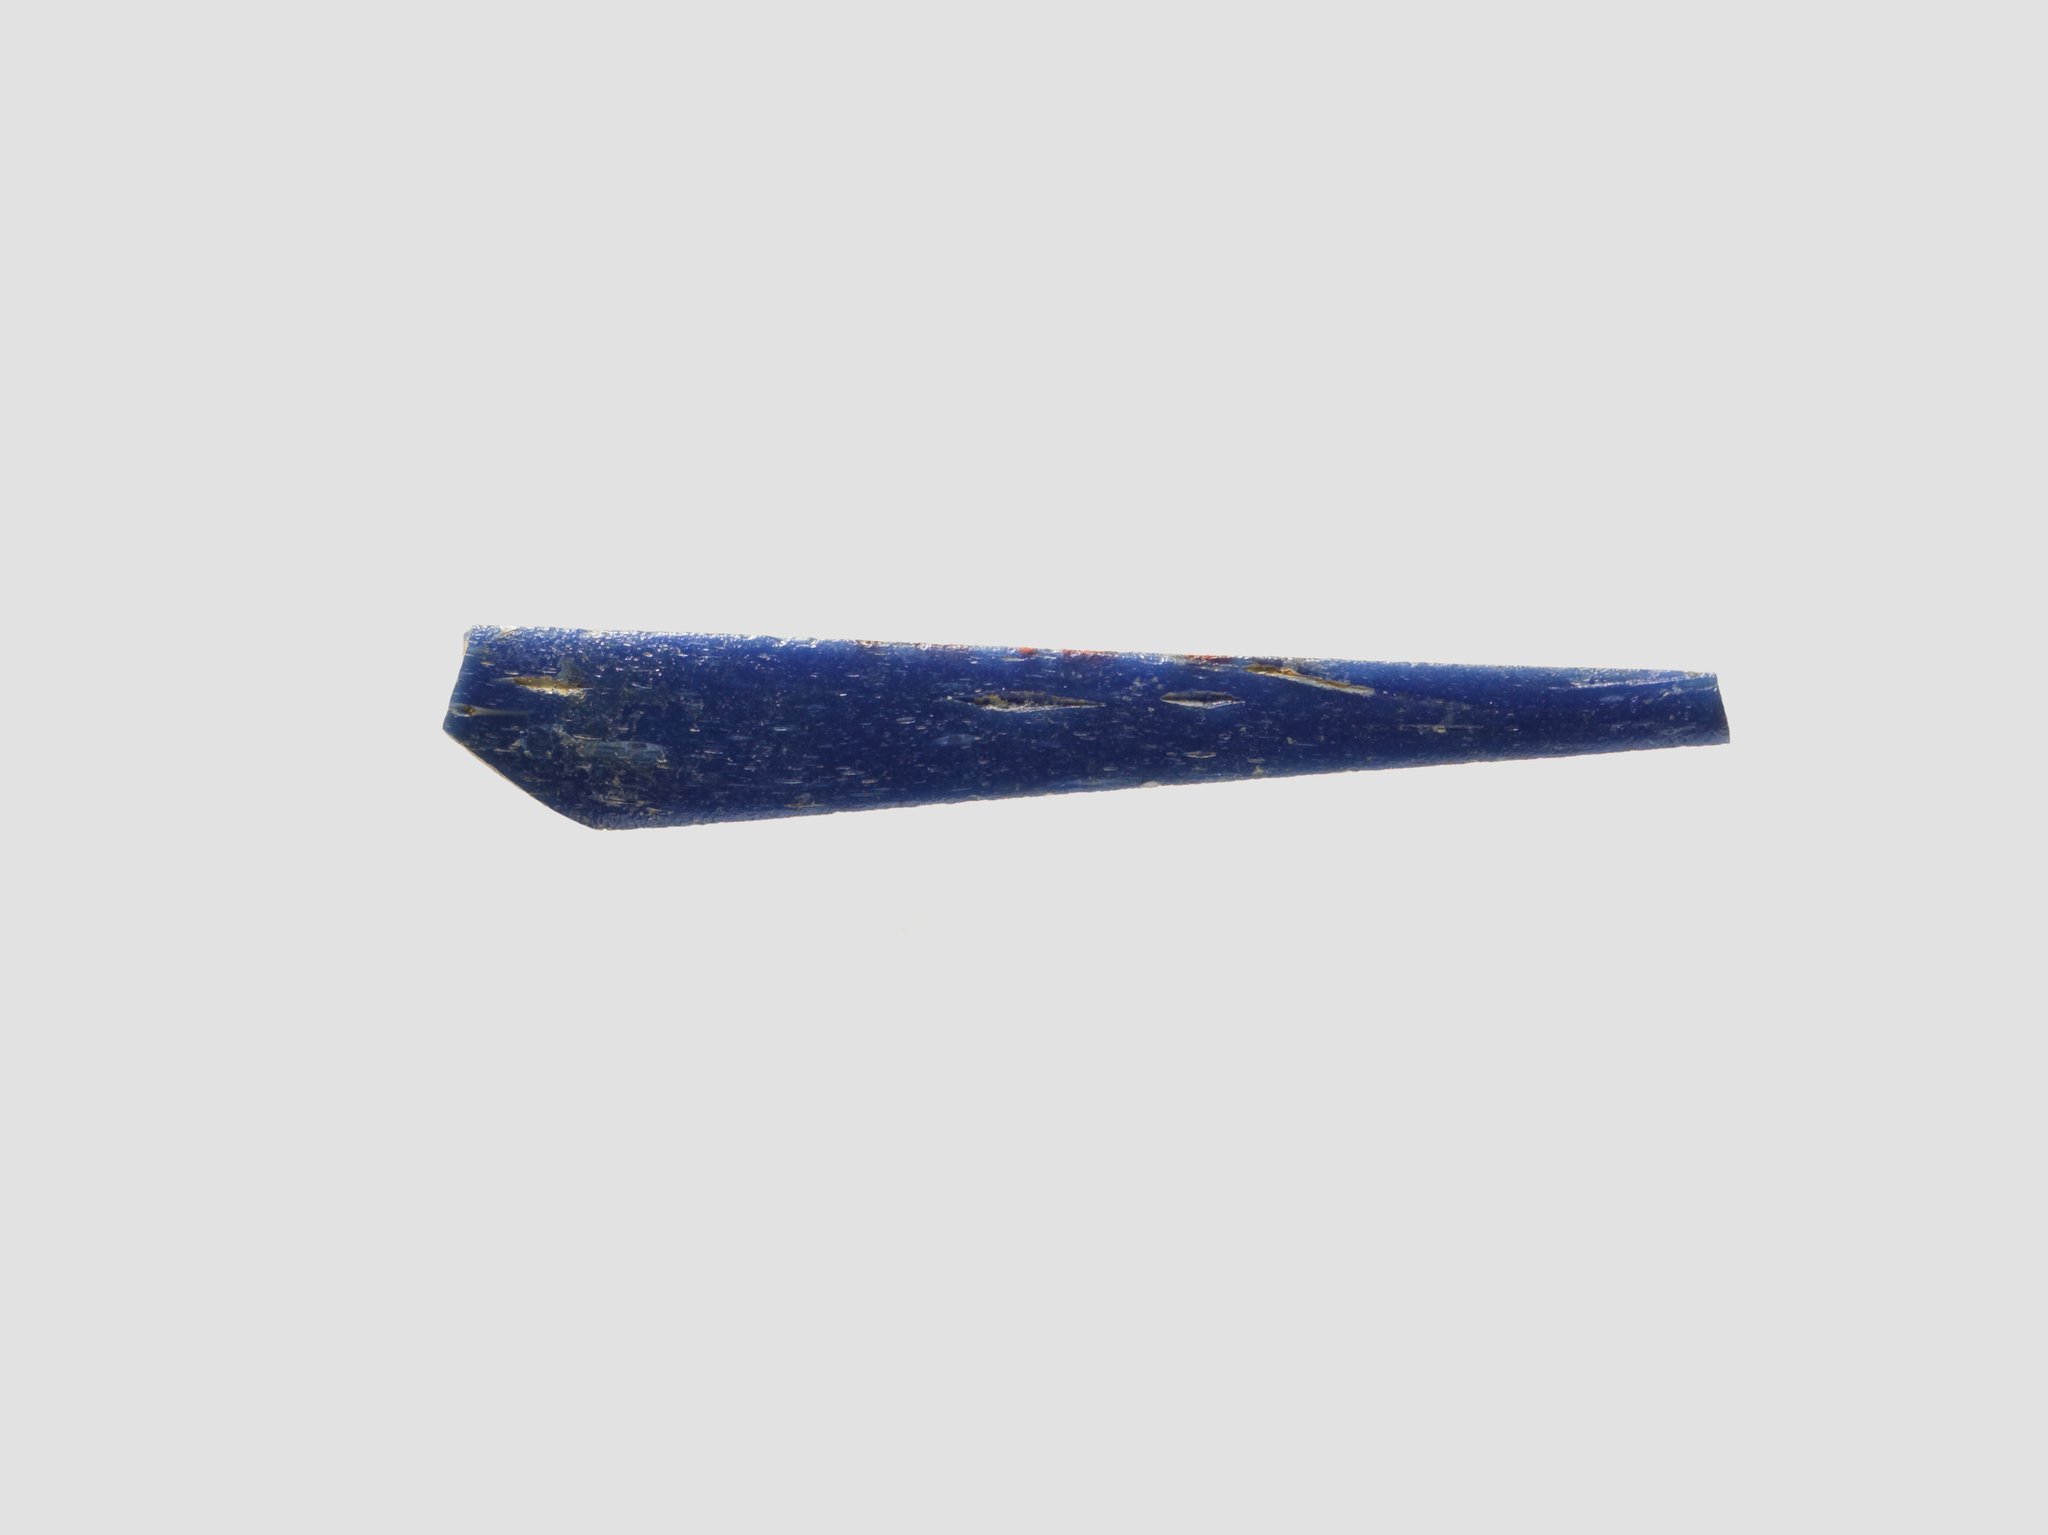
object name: inlay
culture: assyrian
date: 800-601 BCE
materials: glass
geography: mesopotamia